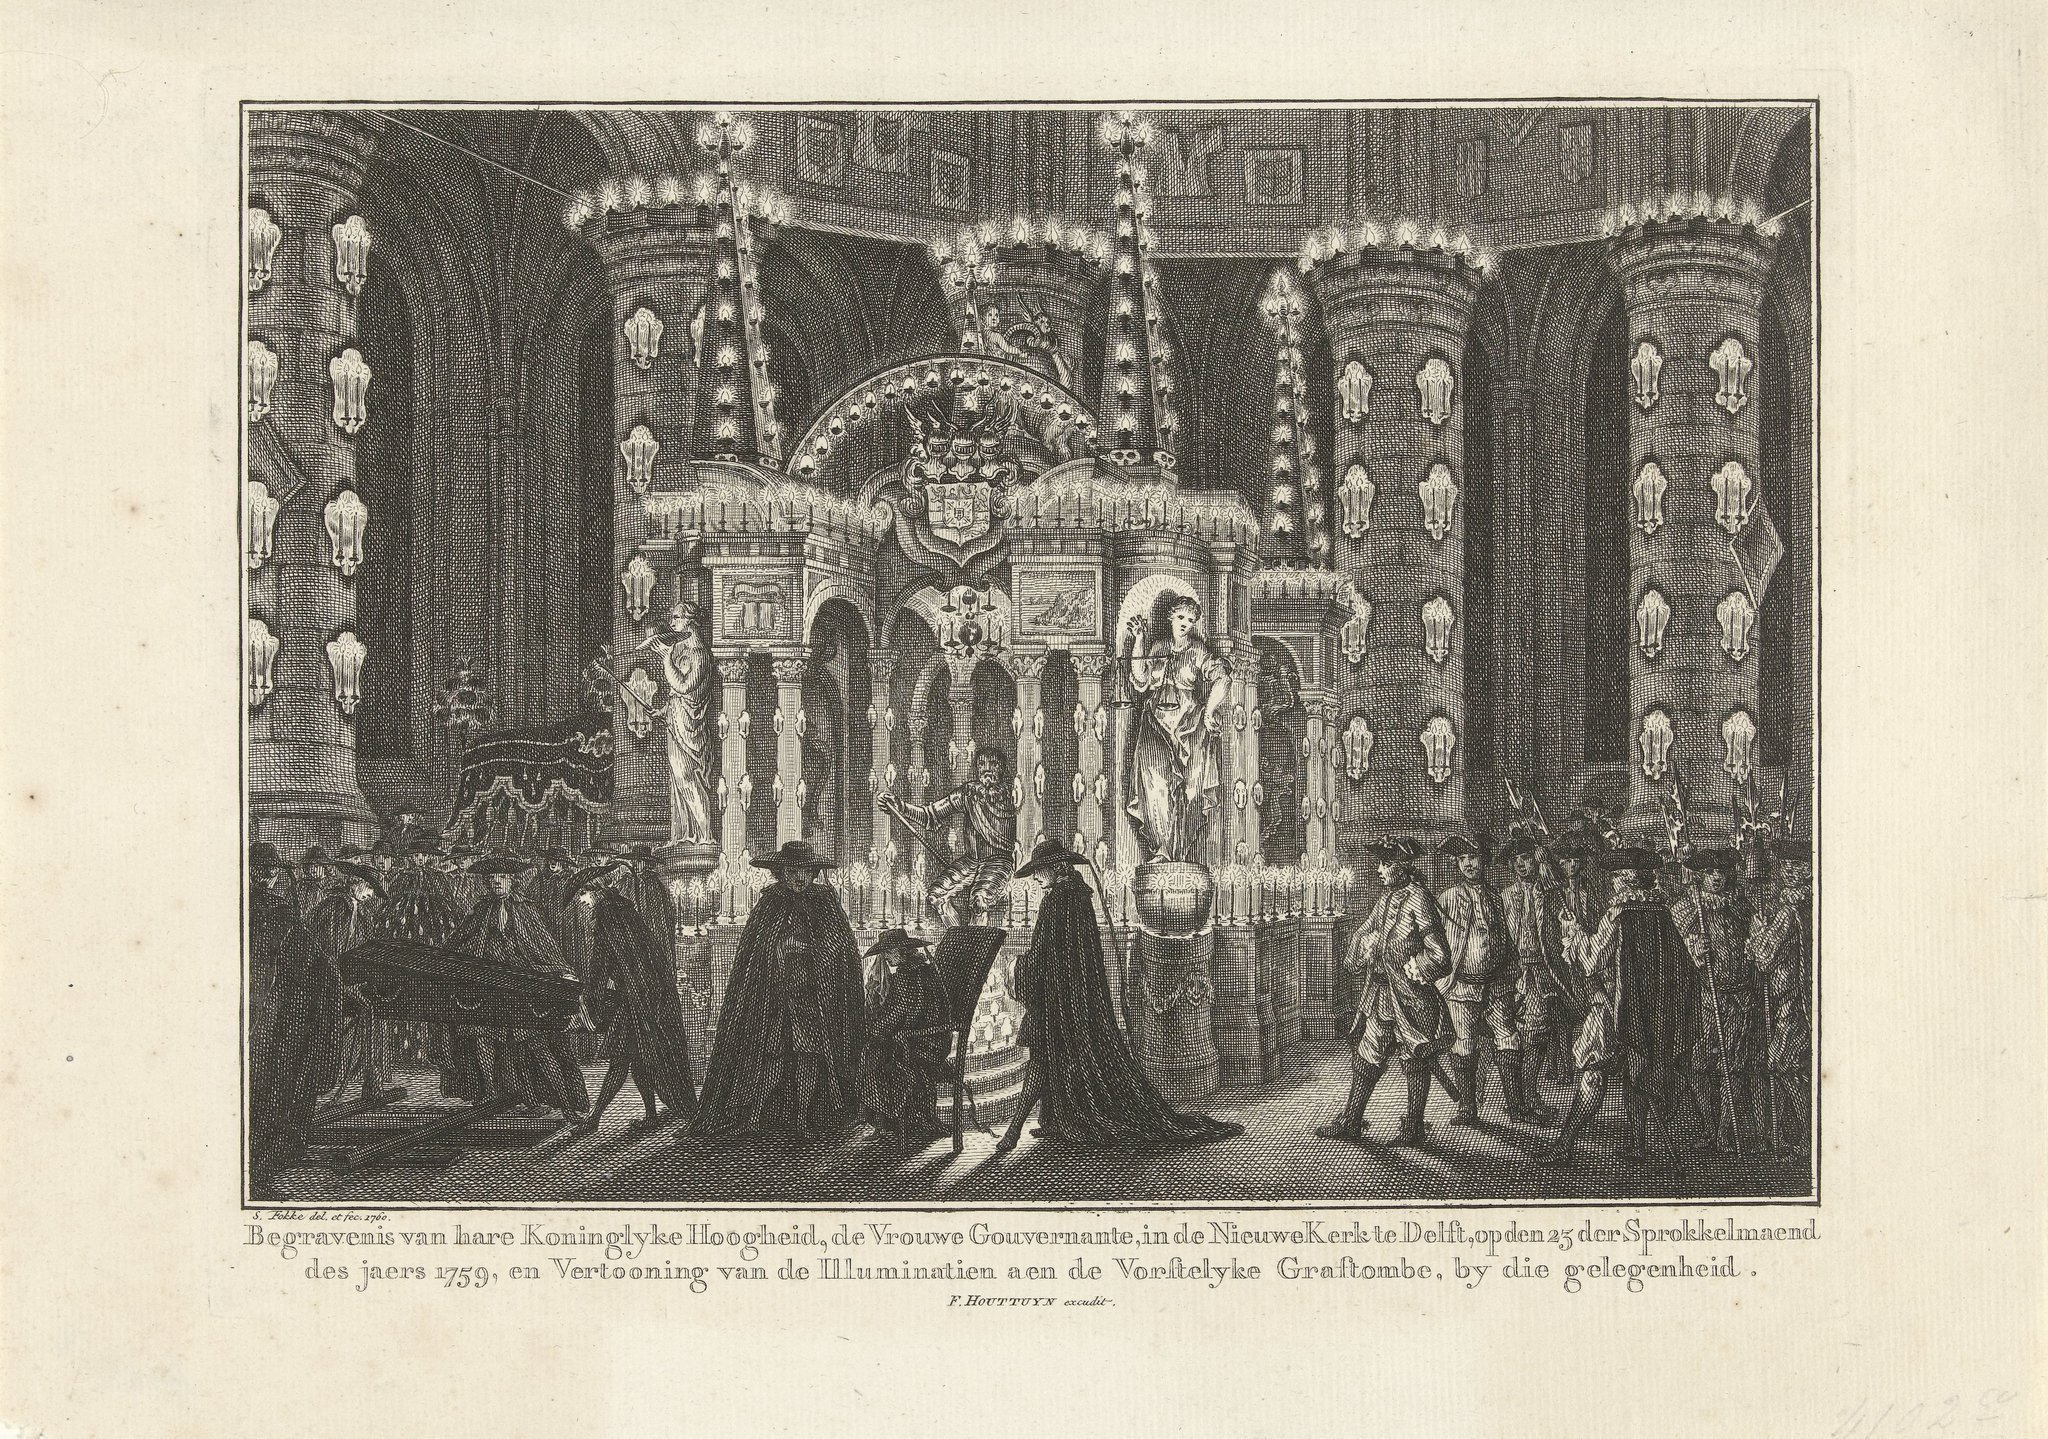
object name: print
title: Begravenis van hare Koninglyke Hoogheid, de Vrouwe Gouvernante, in de Nieuwe Kerk te Delft, op den 23 der Sprokkelmaend des jaers 1759, en Vertooning van de Illuminatien aen de Vorstelyke Graftombe, by die gelegenheid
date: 1760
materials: paper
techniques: engraving, etching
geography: northern netherlands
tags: the hague, anna van hannover, burial, grave-building, monumental tomb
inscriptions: collector's mark: Lugt 2228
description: Begrafenis van Anna van Hannover, prinses van Oranje-Nassau, in de Nieuwe Kerk te Delft op 23 februari 1759. Het interieur van de kerk en het praalgraf van Willem van Oranje is verlicht met talloze kaarsen.